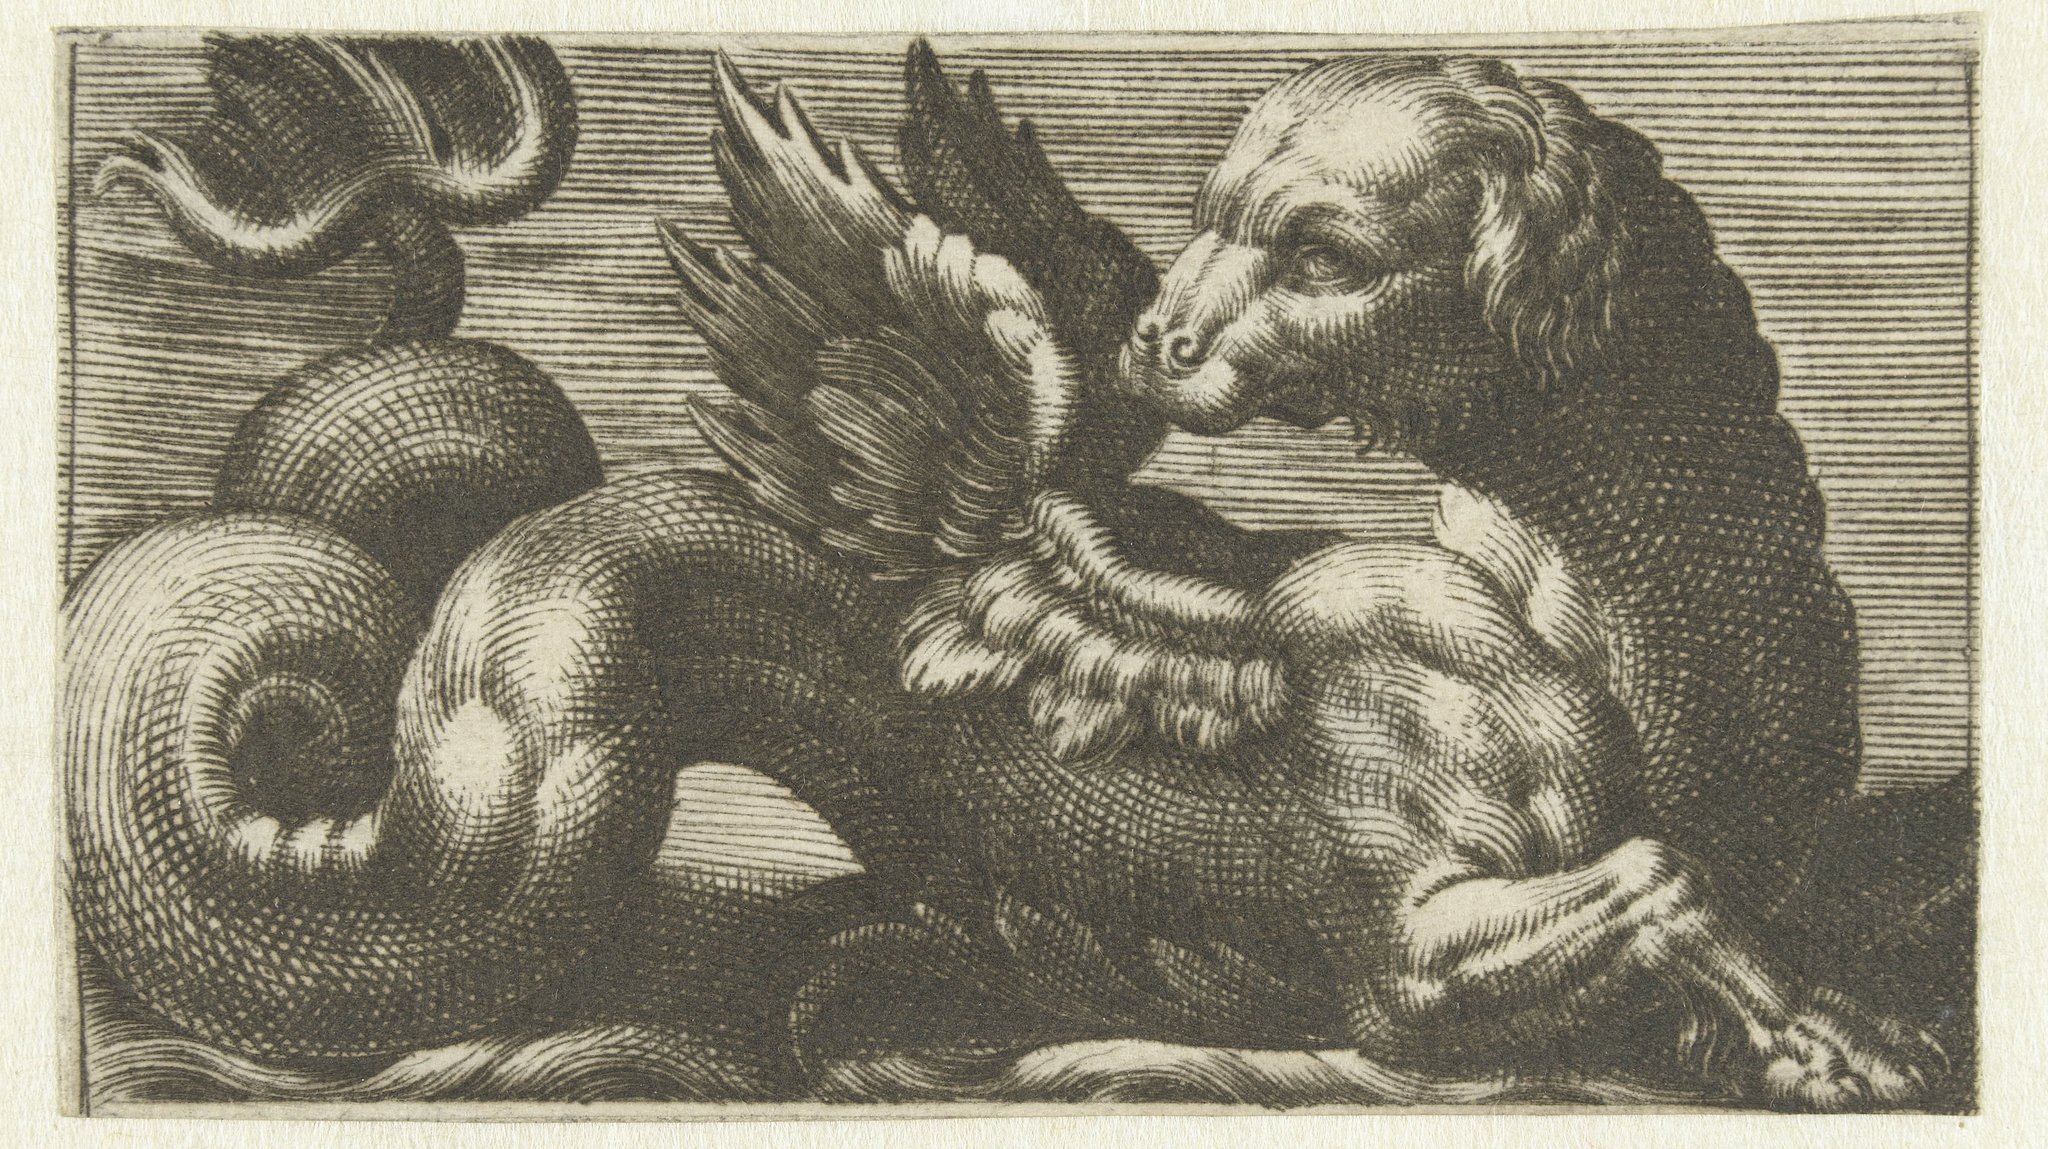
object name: ornament print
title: Friezen met zeemonsters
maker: Anonymous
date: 1580-1610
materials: paper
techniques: engraving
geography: italy